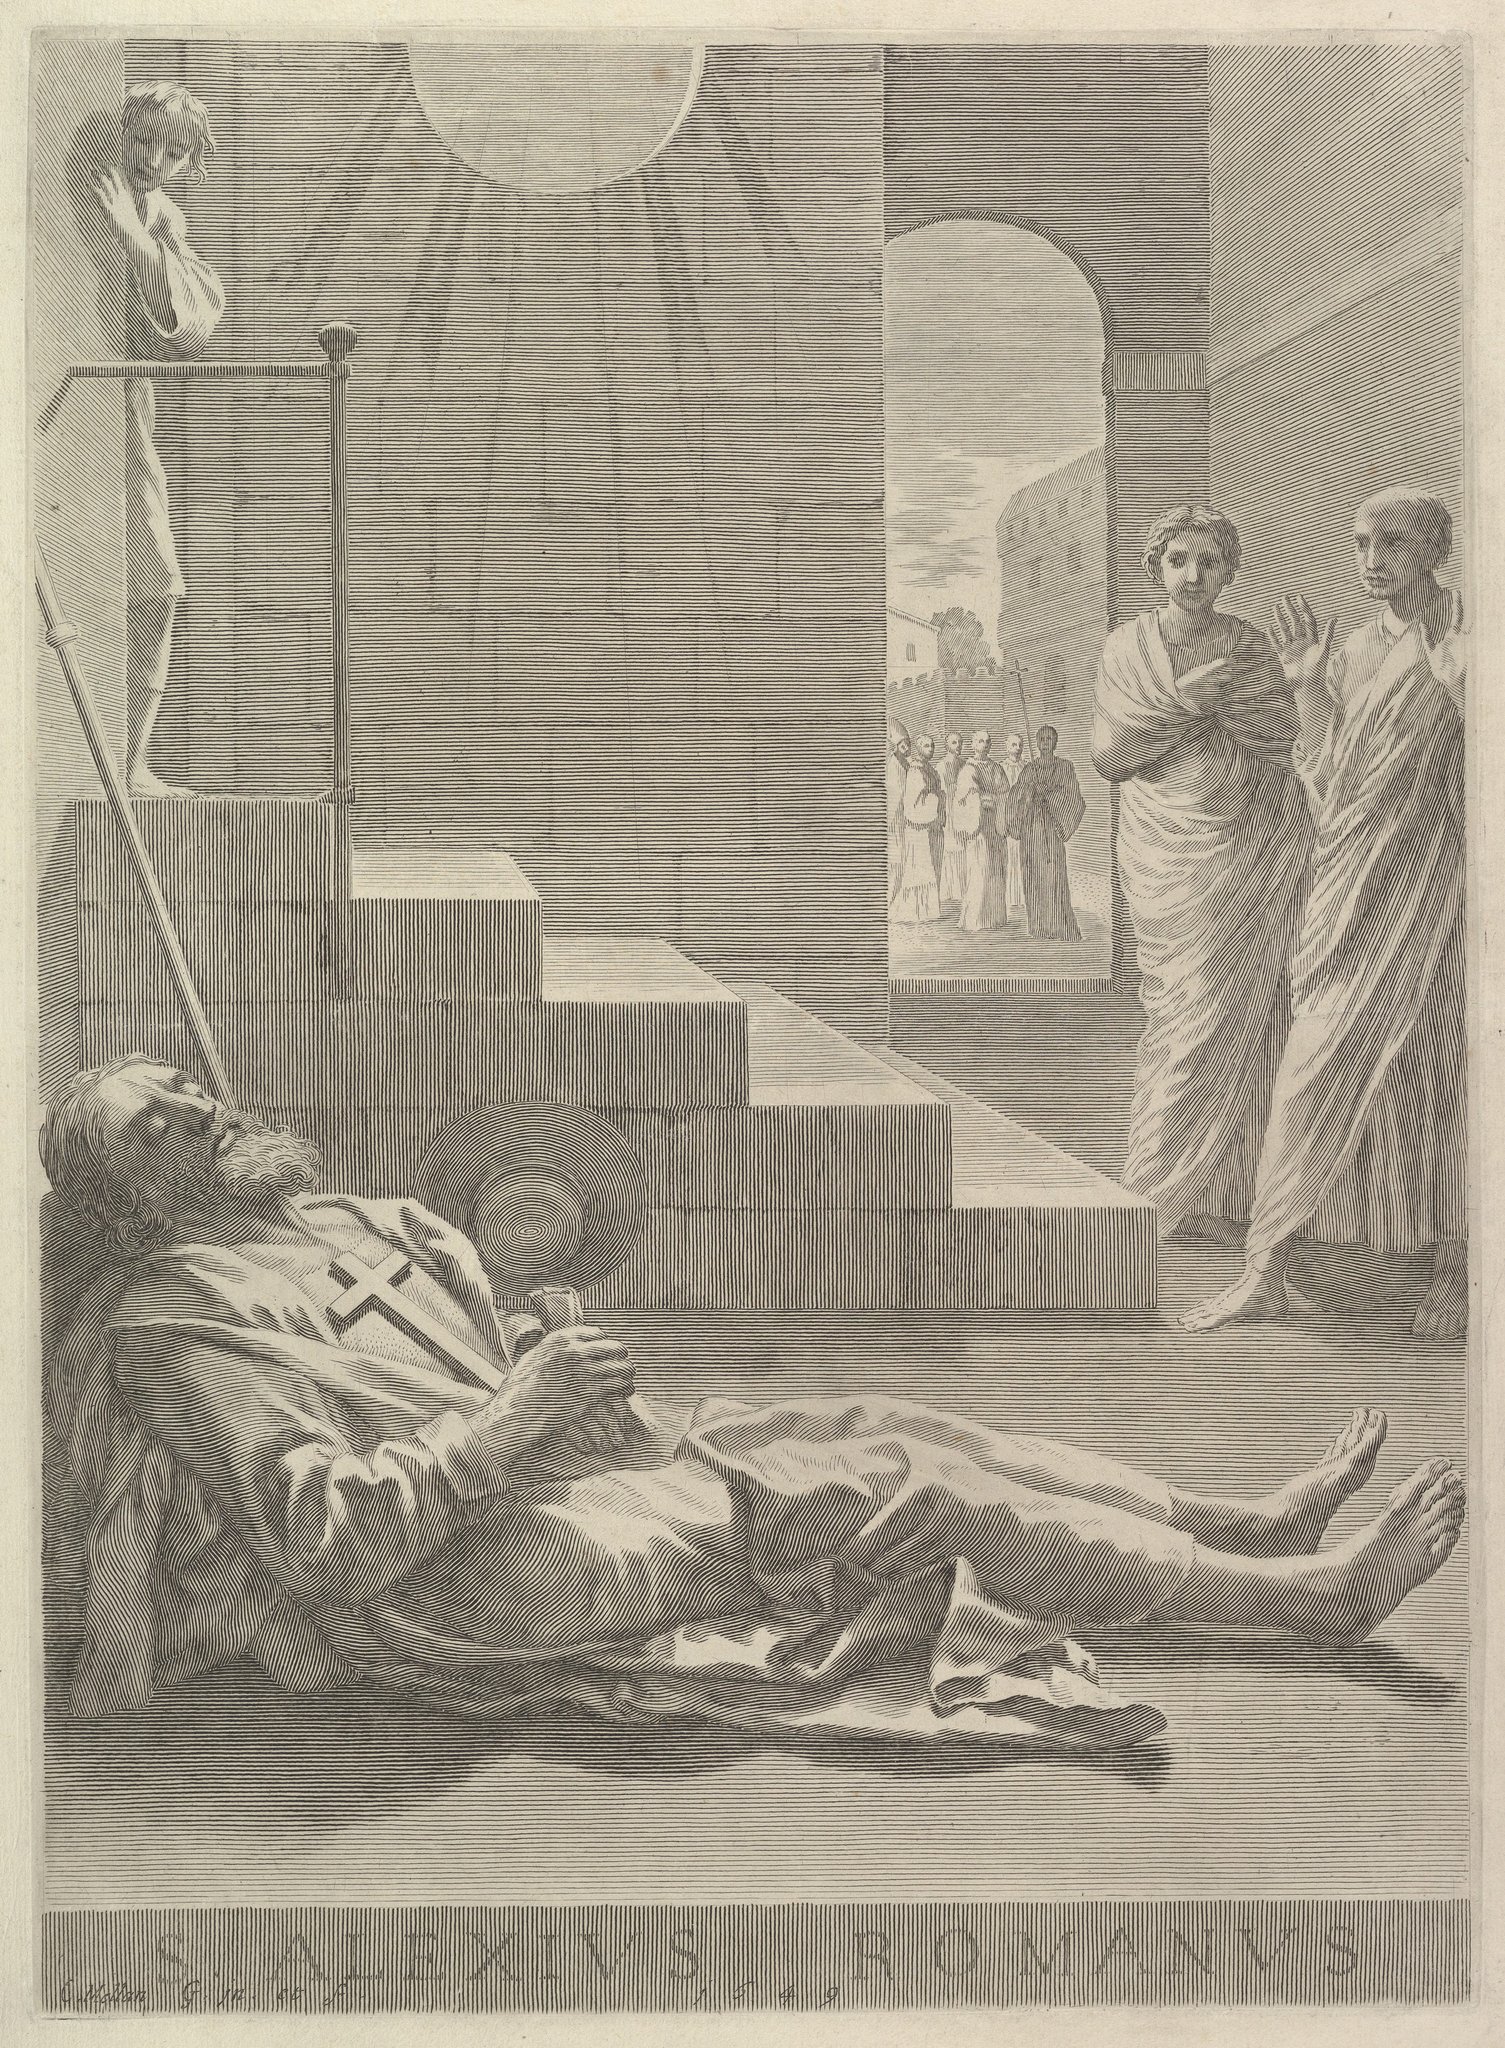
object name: print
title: St. Alexis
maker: claude mellan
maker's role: artist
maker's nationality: french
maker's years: 1598-1688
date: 1649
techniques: engraving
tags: men,women,cross,saints